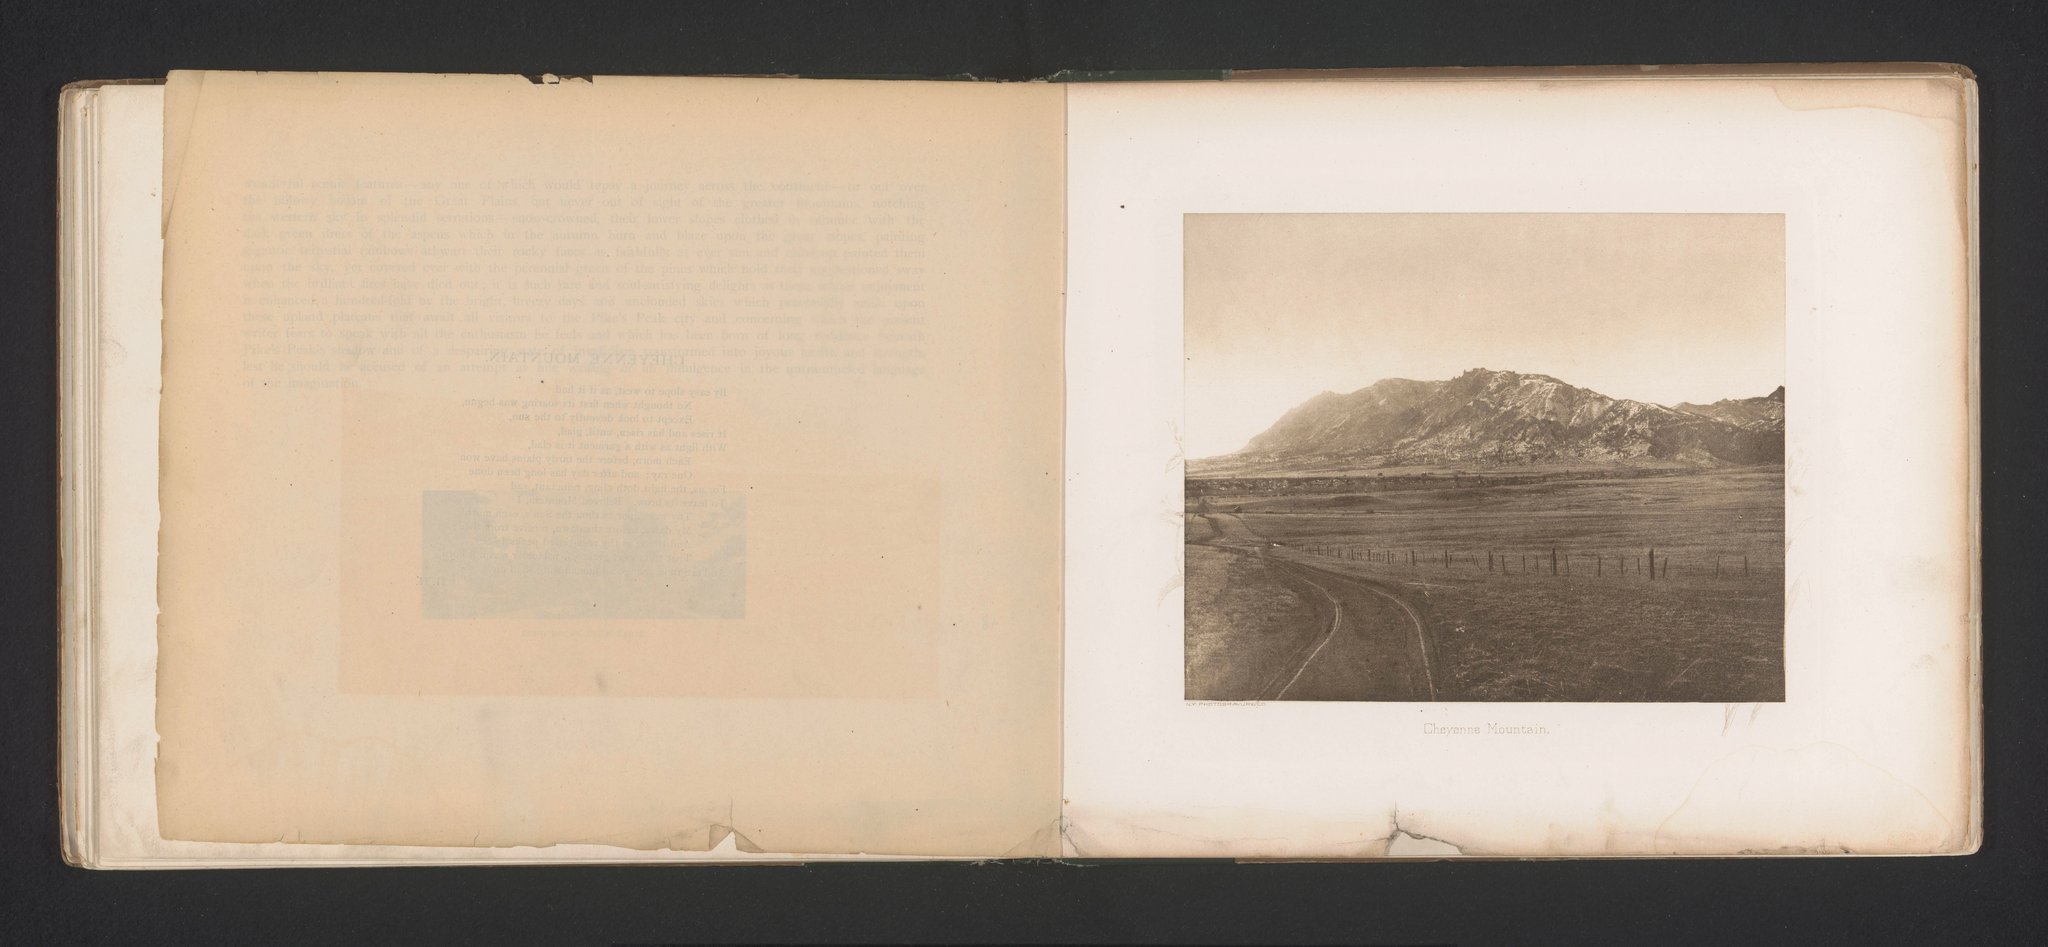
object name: photomechanical print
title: Gezicht op Cheyenne Mountain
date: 1888-1893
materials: paper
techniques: photoaquatint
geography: colorado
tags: landscapes, mountains